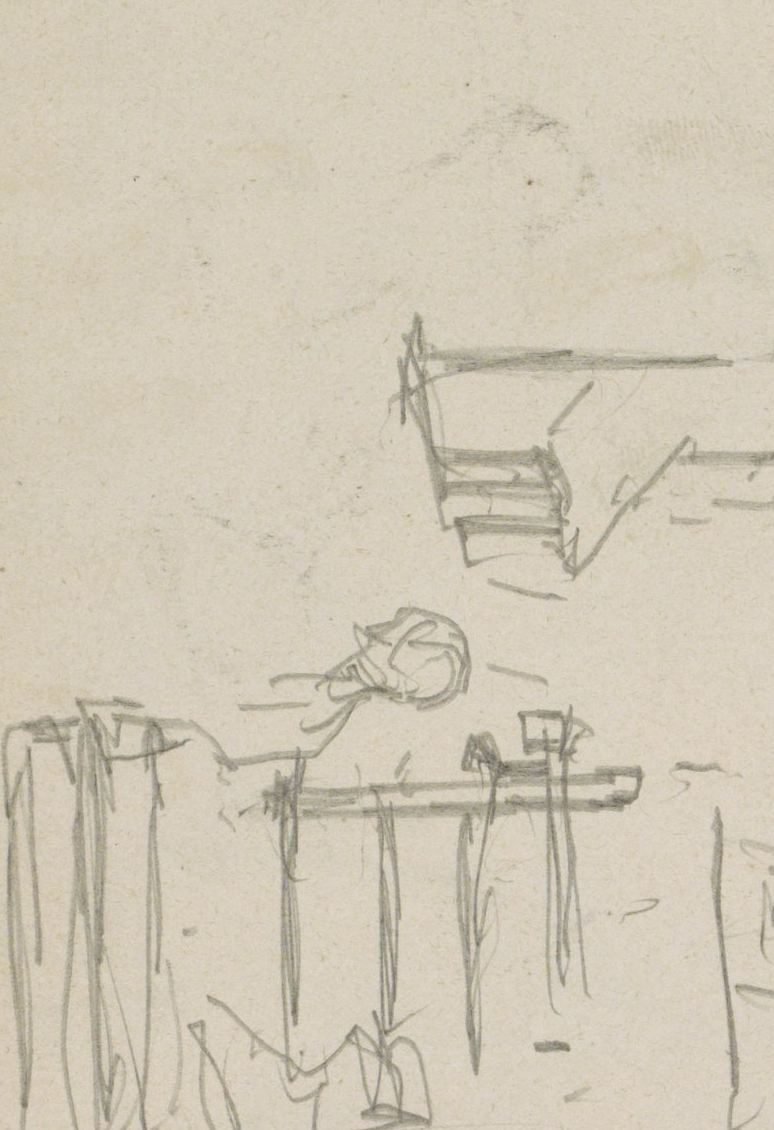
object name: sketchbook leaf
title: Bordes op de hoek van het Haarlemmerplein en de Kleine Houtstraat te Amsterdam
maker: george hendrik breitner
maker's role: draughtsman, painter, print maker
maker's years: 1857-1923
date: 1886-1908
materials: paper, pencil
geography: amsterdam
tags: urban housing, street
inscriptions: annotation: ‘Whistler./ The Building of new Westminster/ Bridge/ A.A. Pope [...]’, annotation: ‘hoek Haarl. plein en kl. Houtstr stoep’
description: Pagina 89 uit een schetsboek met 46 bladen vervaardigd te Amsterdam, Haarlem en Antwerpen.